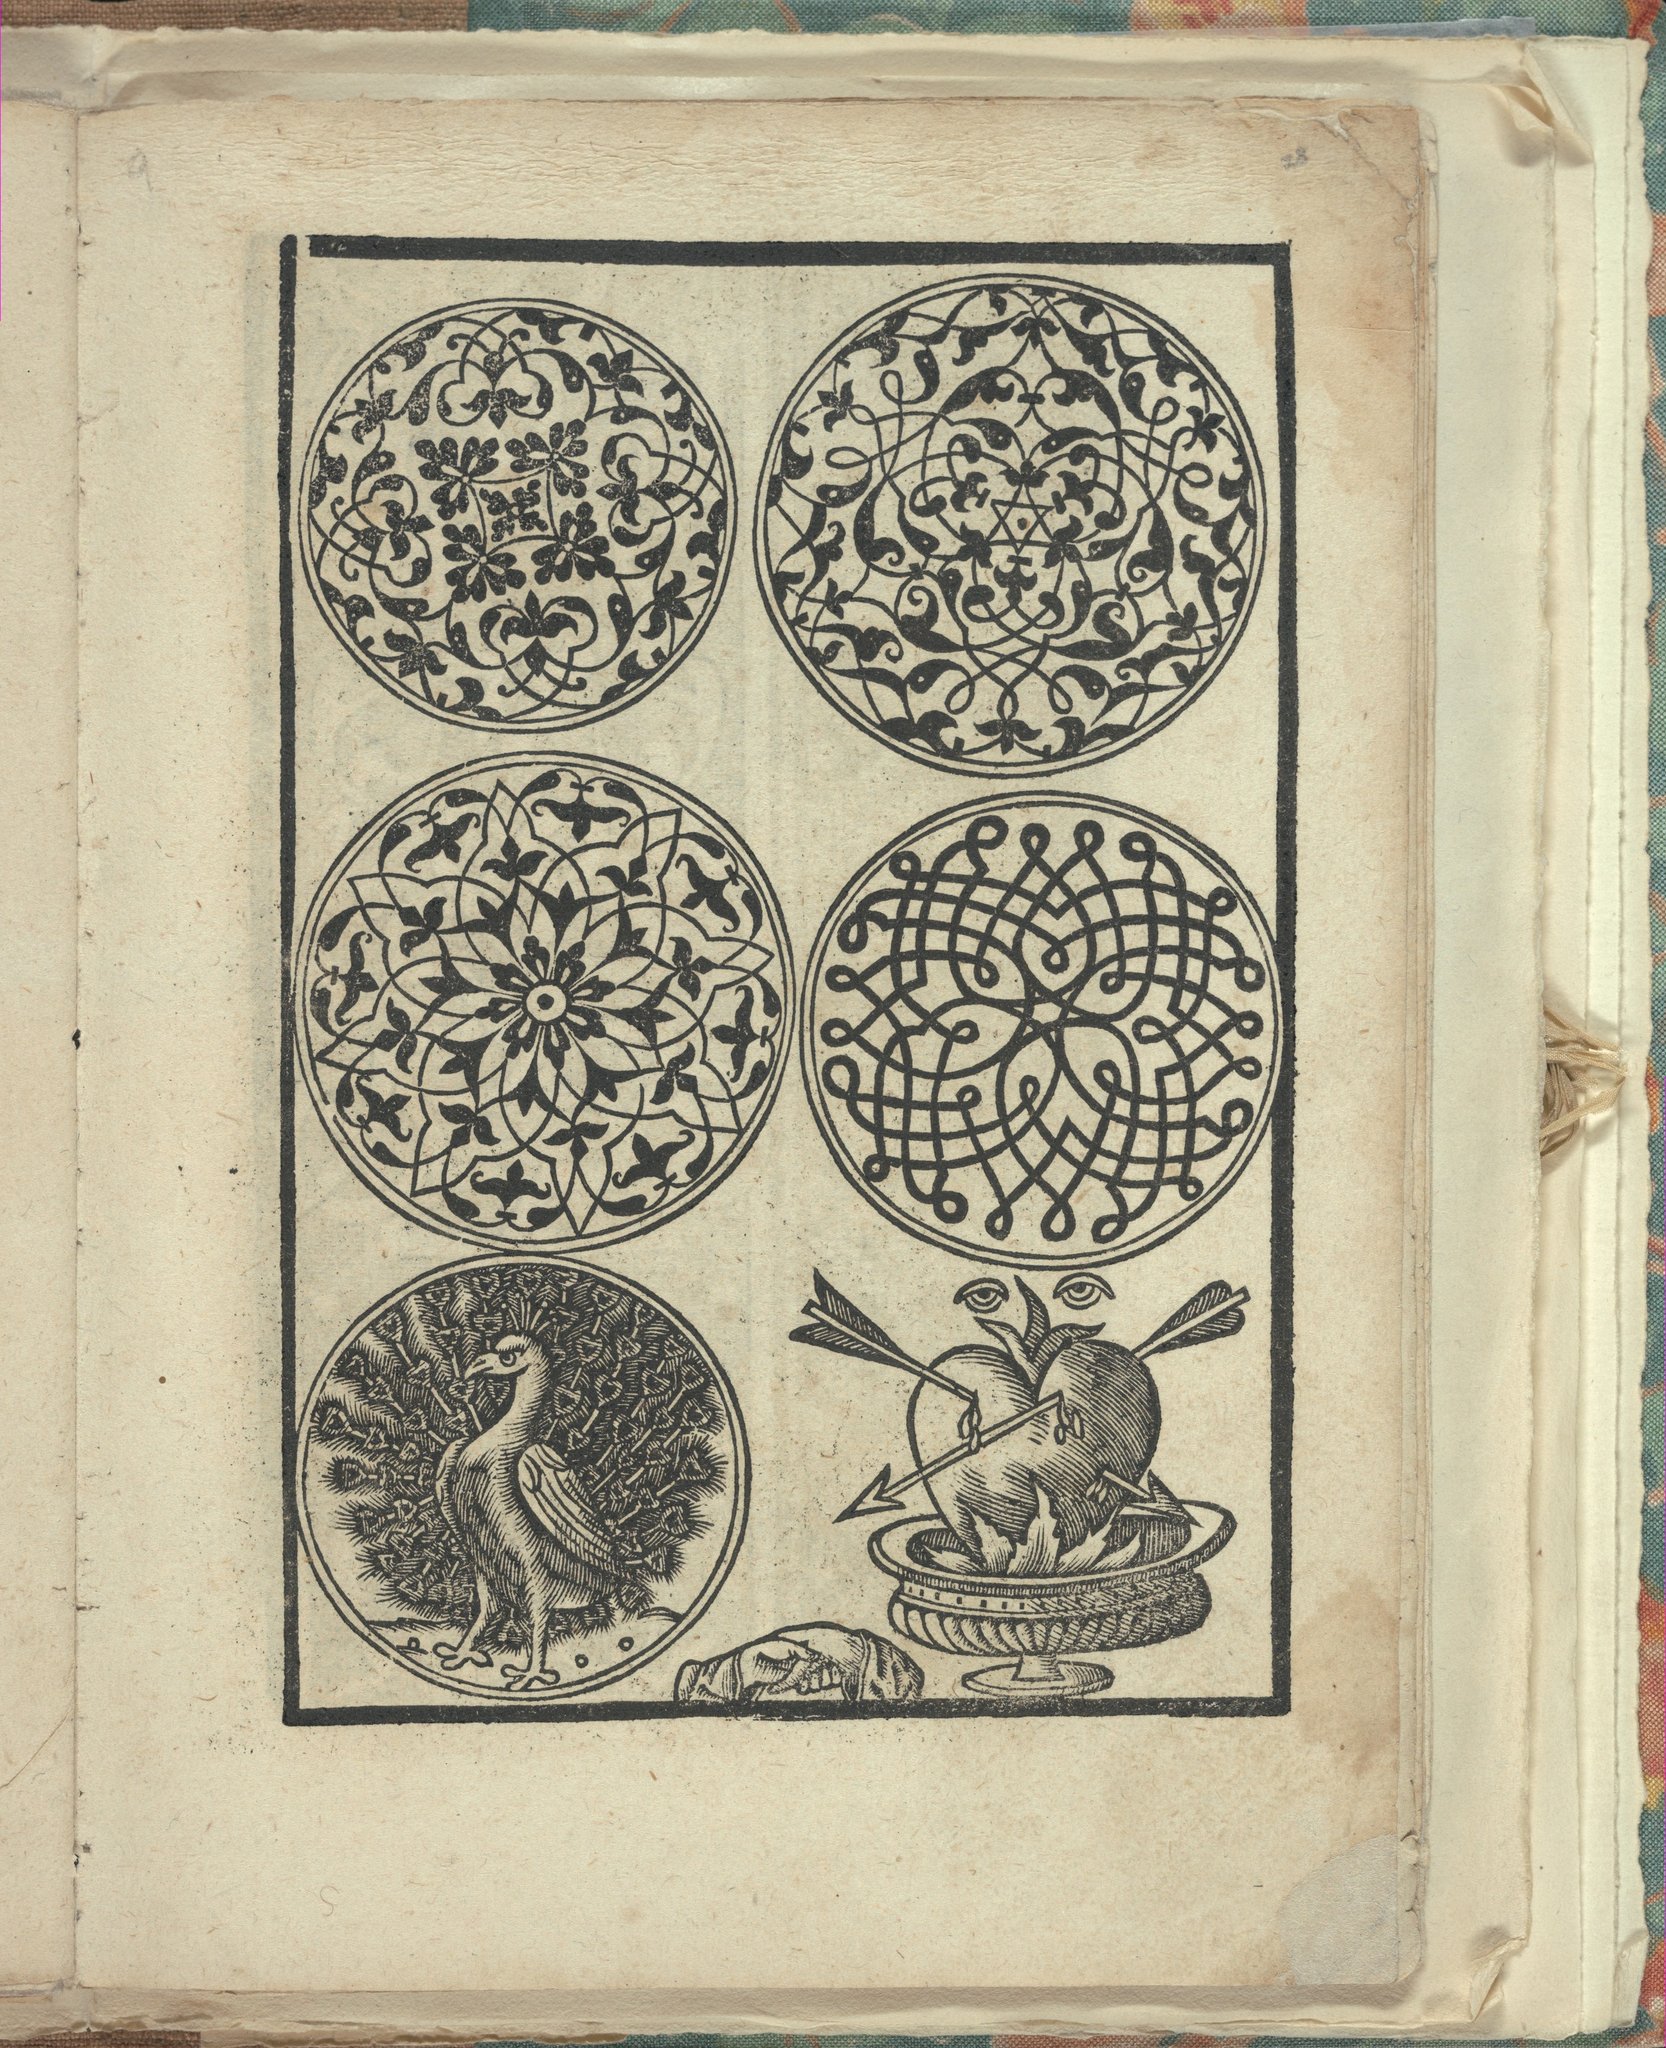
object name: book print ornament architecture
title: Opera Nova Universali intitulata Corona di racammi, page 28 (recto)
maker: giovanni andrea vavassore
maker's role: publisher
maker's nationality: italian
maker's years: 1530-1573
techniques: woodcut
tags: ornament,peacocks